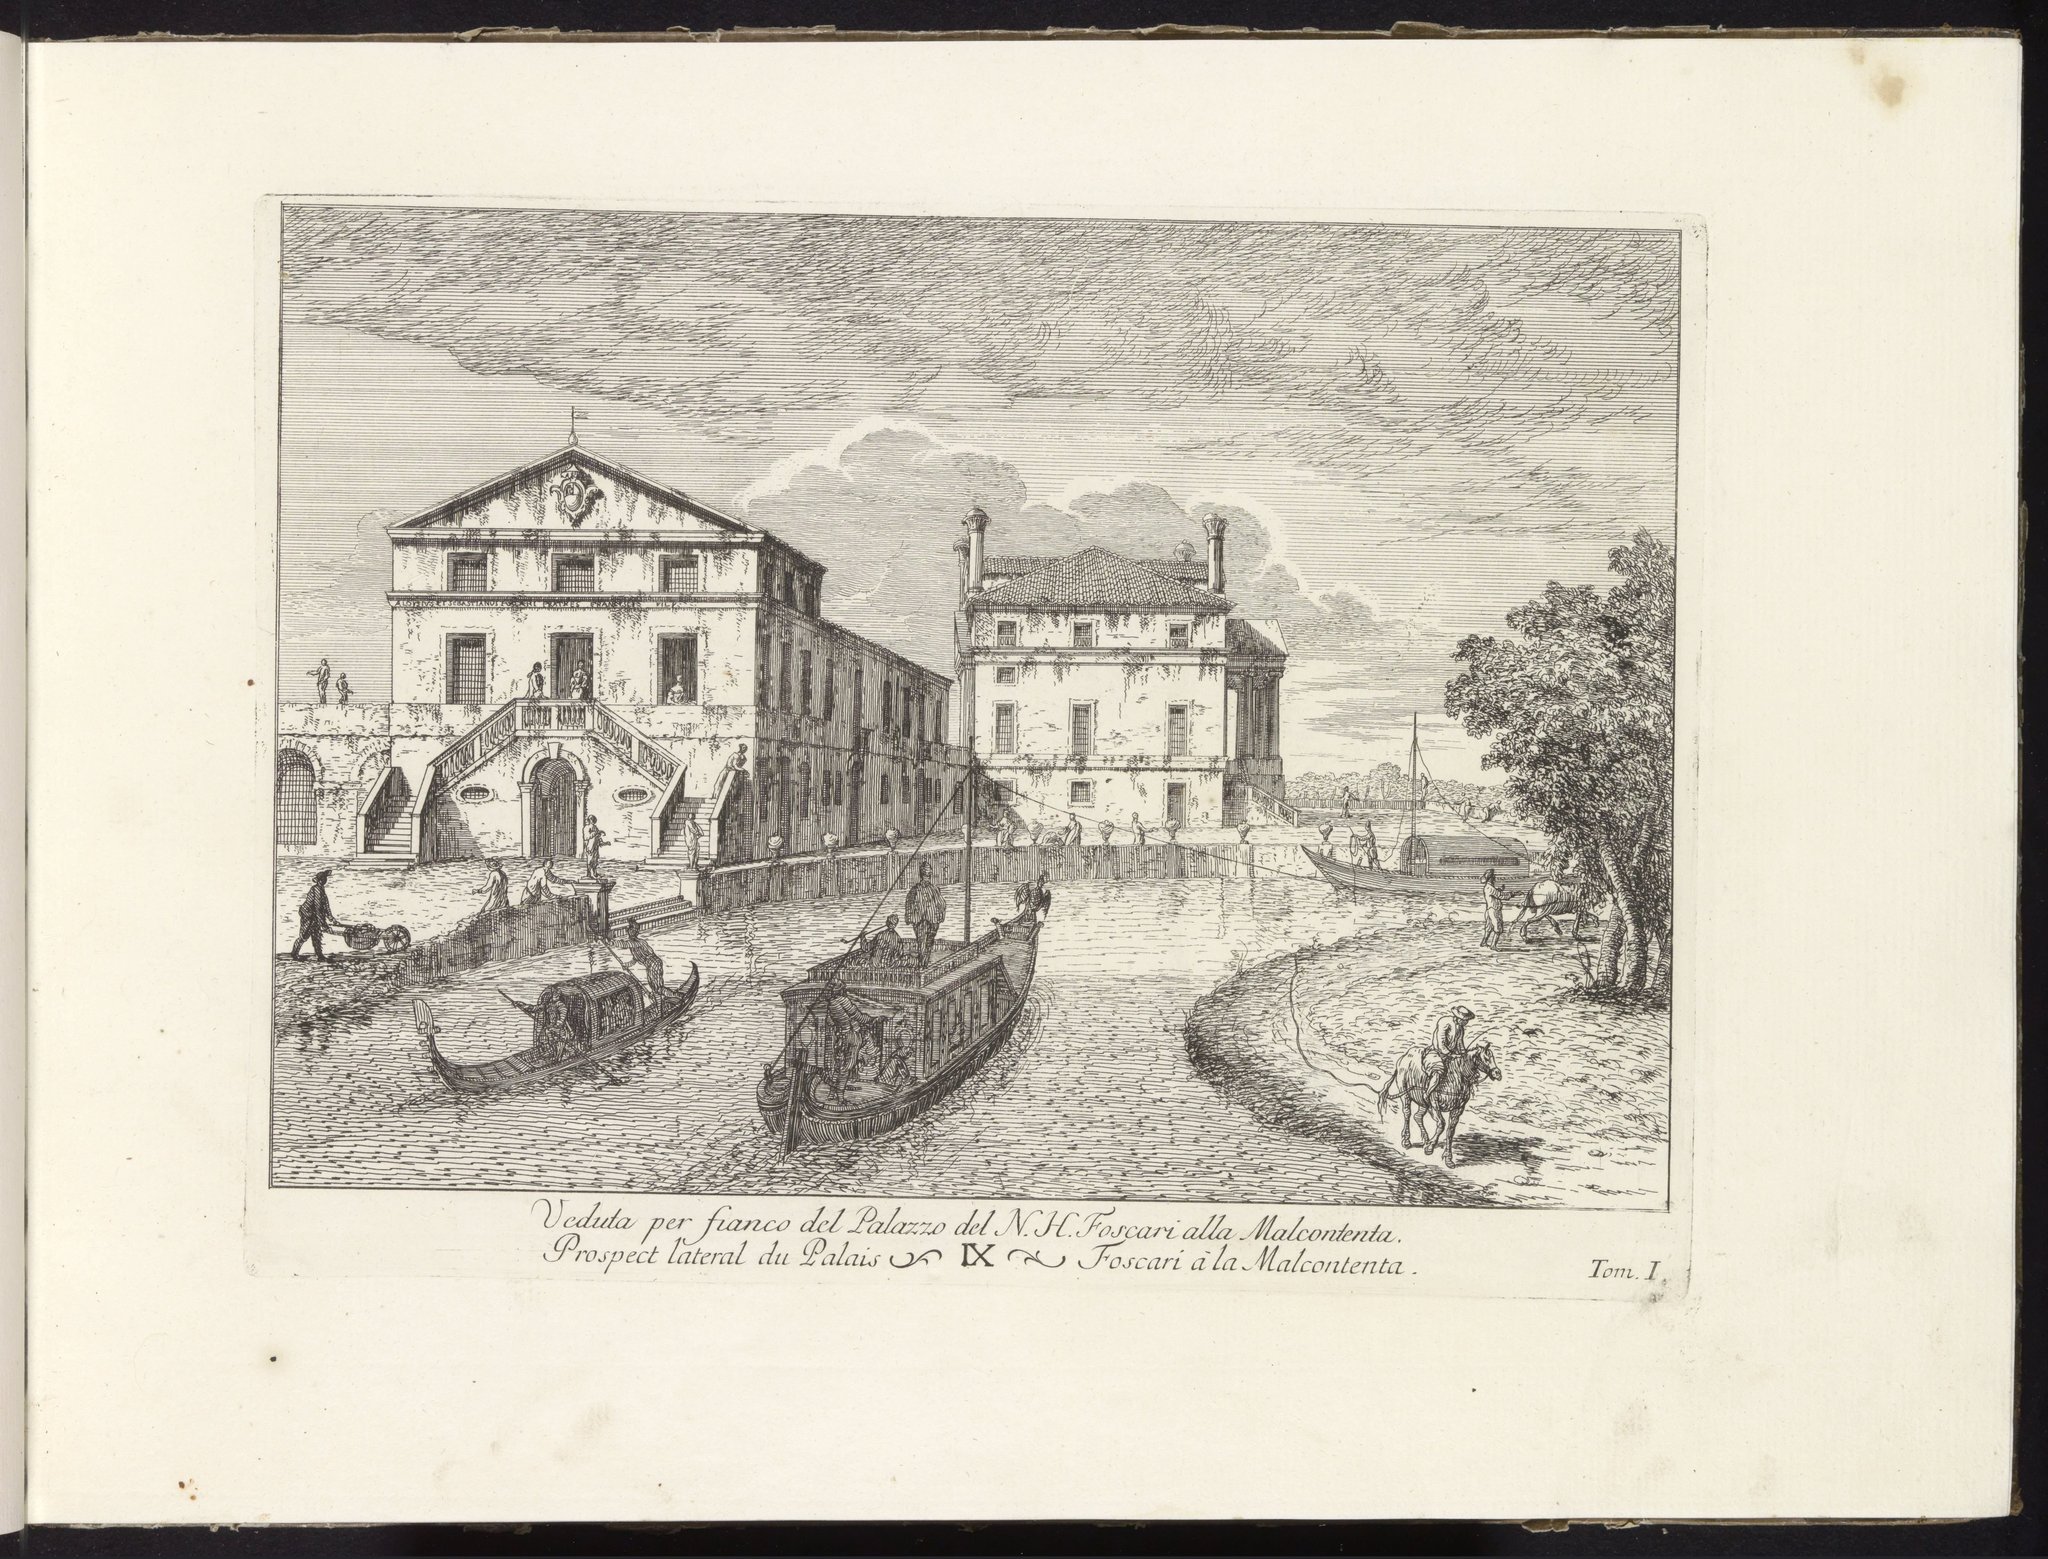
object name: print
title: Les delices de la Brenta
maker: giovanni francesco costa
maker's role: draughtsman, painter, print maker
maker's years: -1773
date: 1750-1760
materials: paper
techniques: etching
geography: venice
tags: river, hôtel, i.e. small palace in city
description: Gezicht op Palazzo del N. H. Foscari aan de rivier de Brenta. Genummerd midden onder: IX en rechtsonder: Tom: I. Deze prent maakt deel uit van een album.